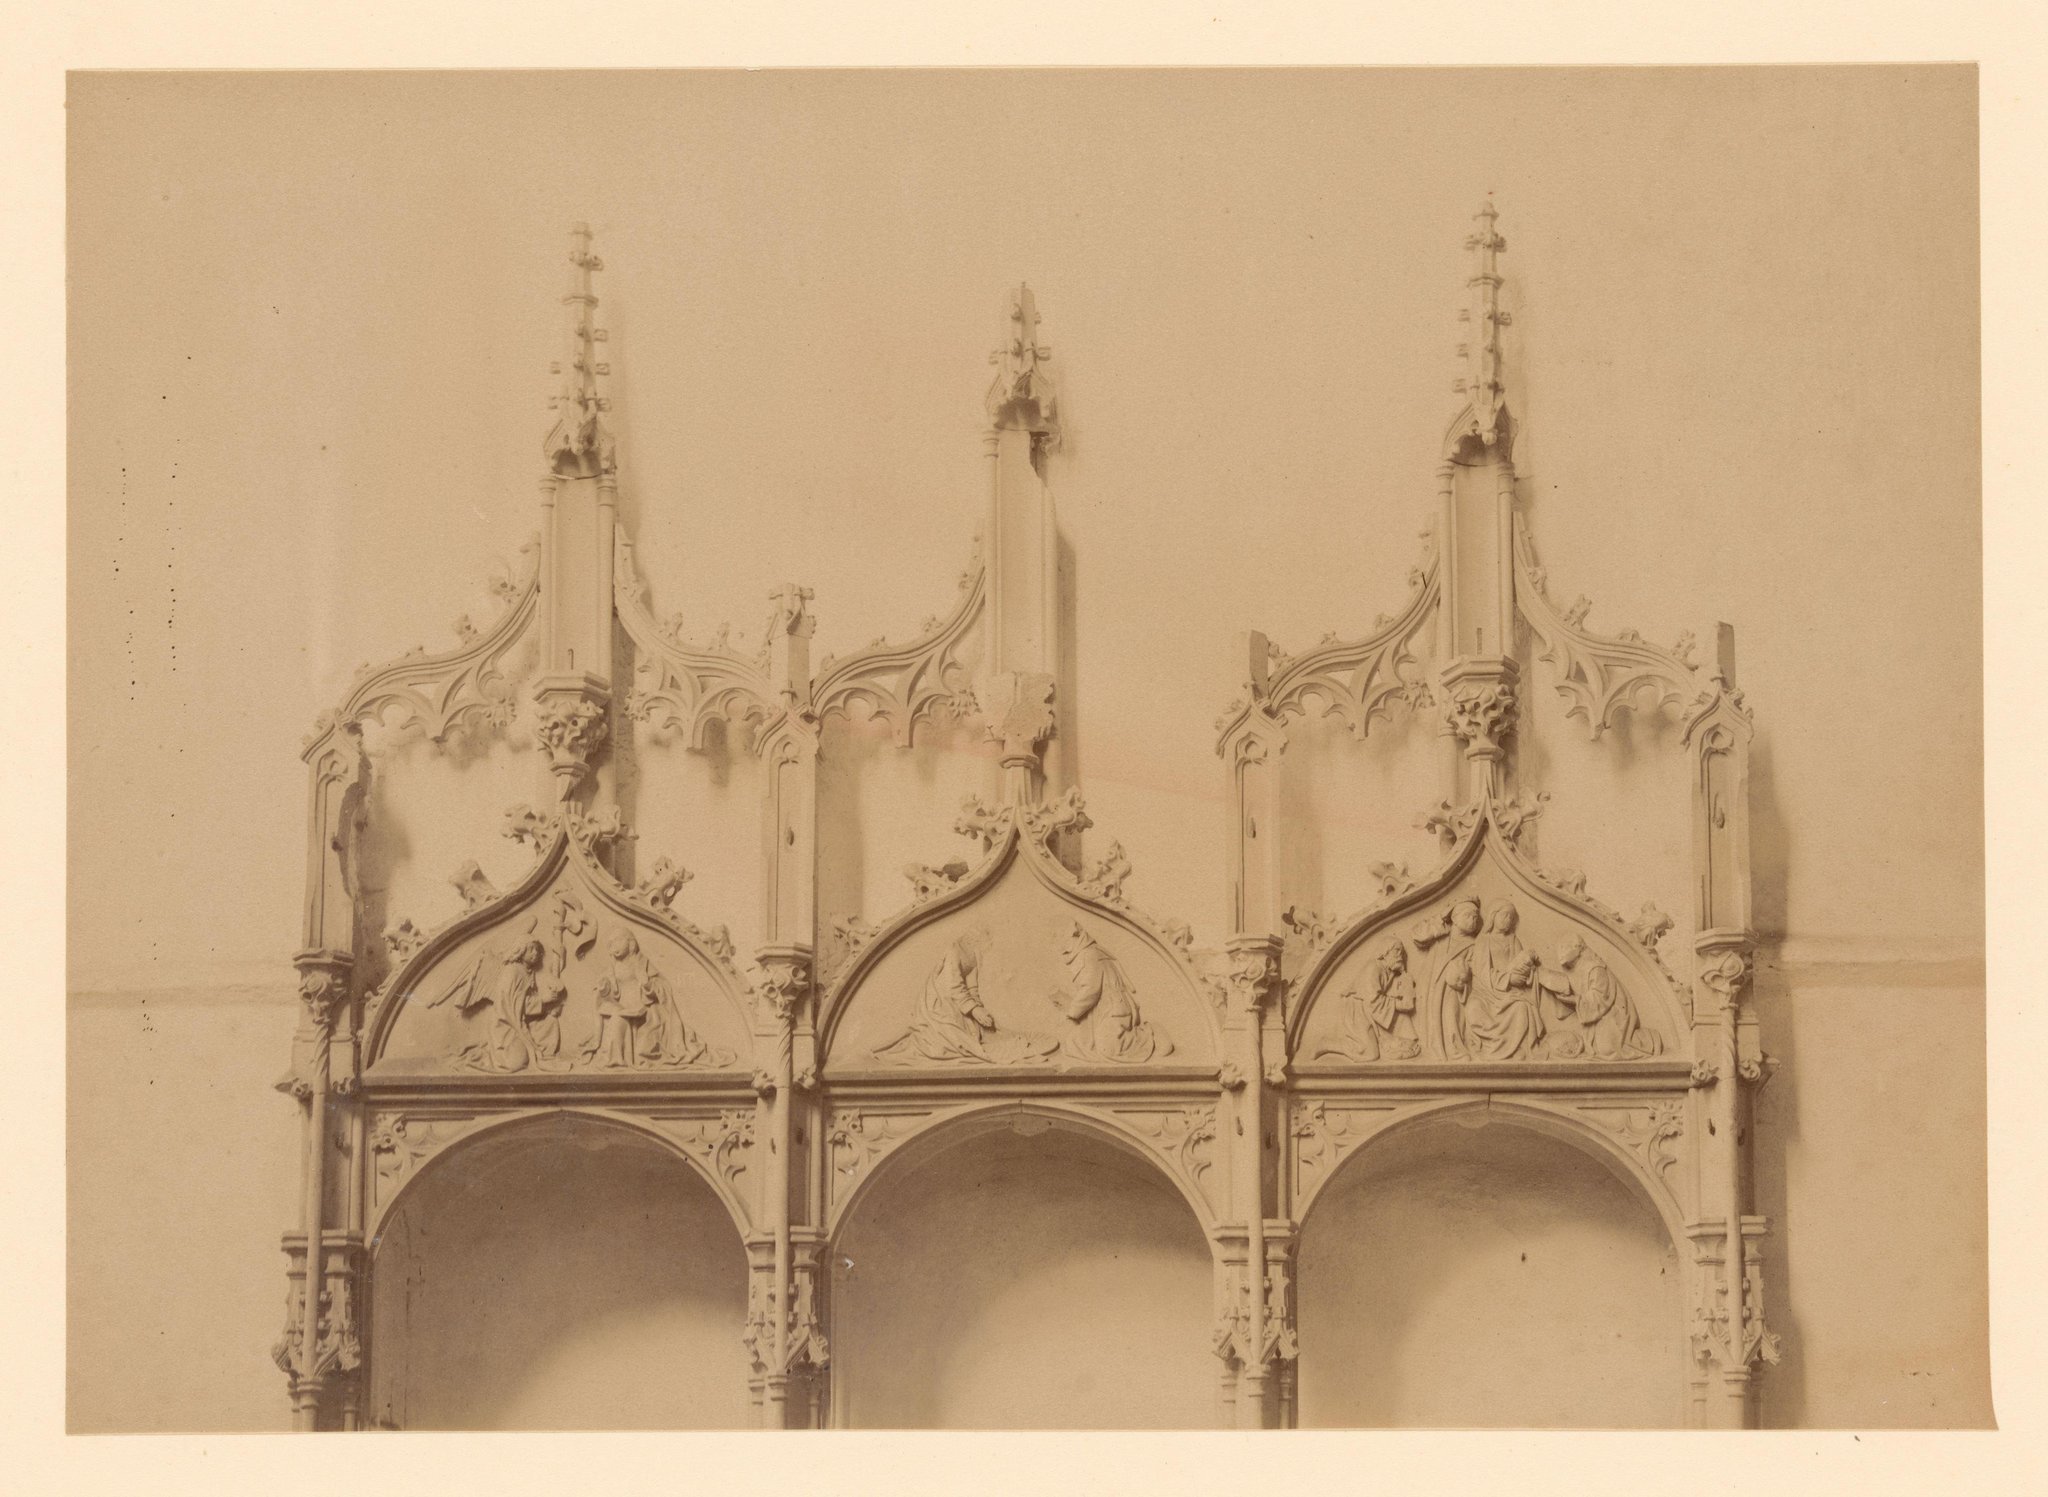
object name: photograph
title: Details van de drie stenen zetels in de Kloosterkerk Ter Apel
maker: anoniem (monumentenzorg)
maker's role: fotograaf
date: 1893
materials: cardboard, photographic support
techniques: albumen print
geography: ter apel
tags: chair (+ stone), interior of church, sculpture (+ relief ~ sculpture)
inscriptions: annotation: ‘Ter Apel’, annotation: ‘Ter Apel/ Bovengedeelte der 3 steenen zitplaatsen tegen den zuidwand van het koor der kerk/ sept 1893’